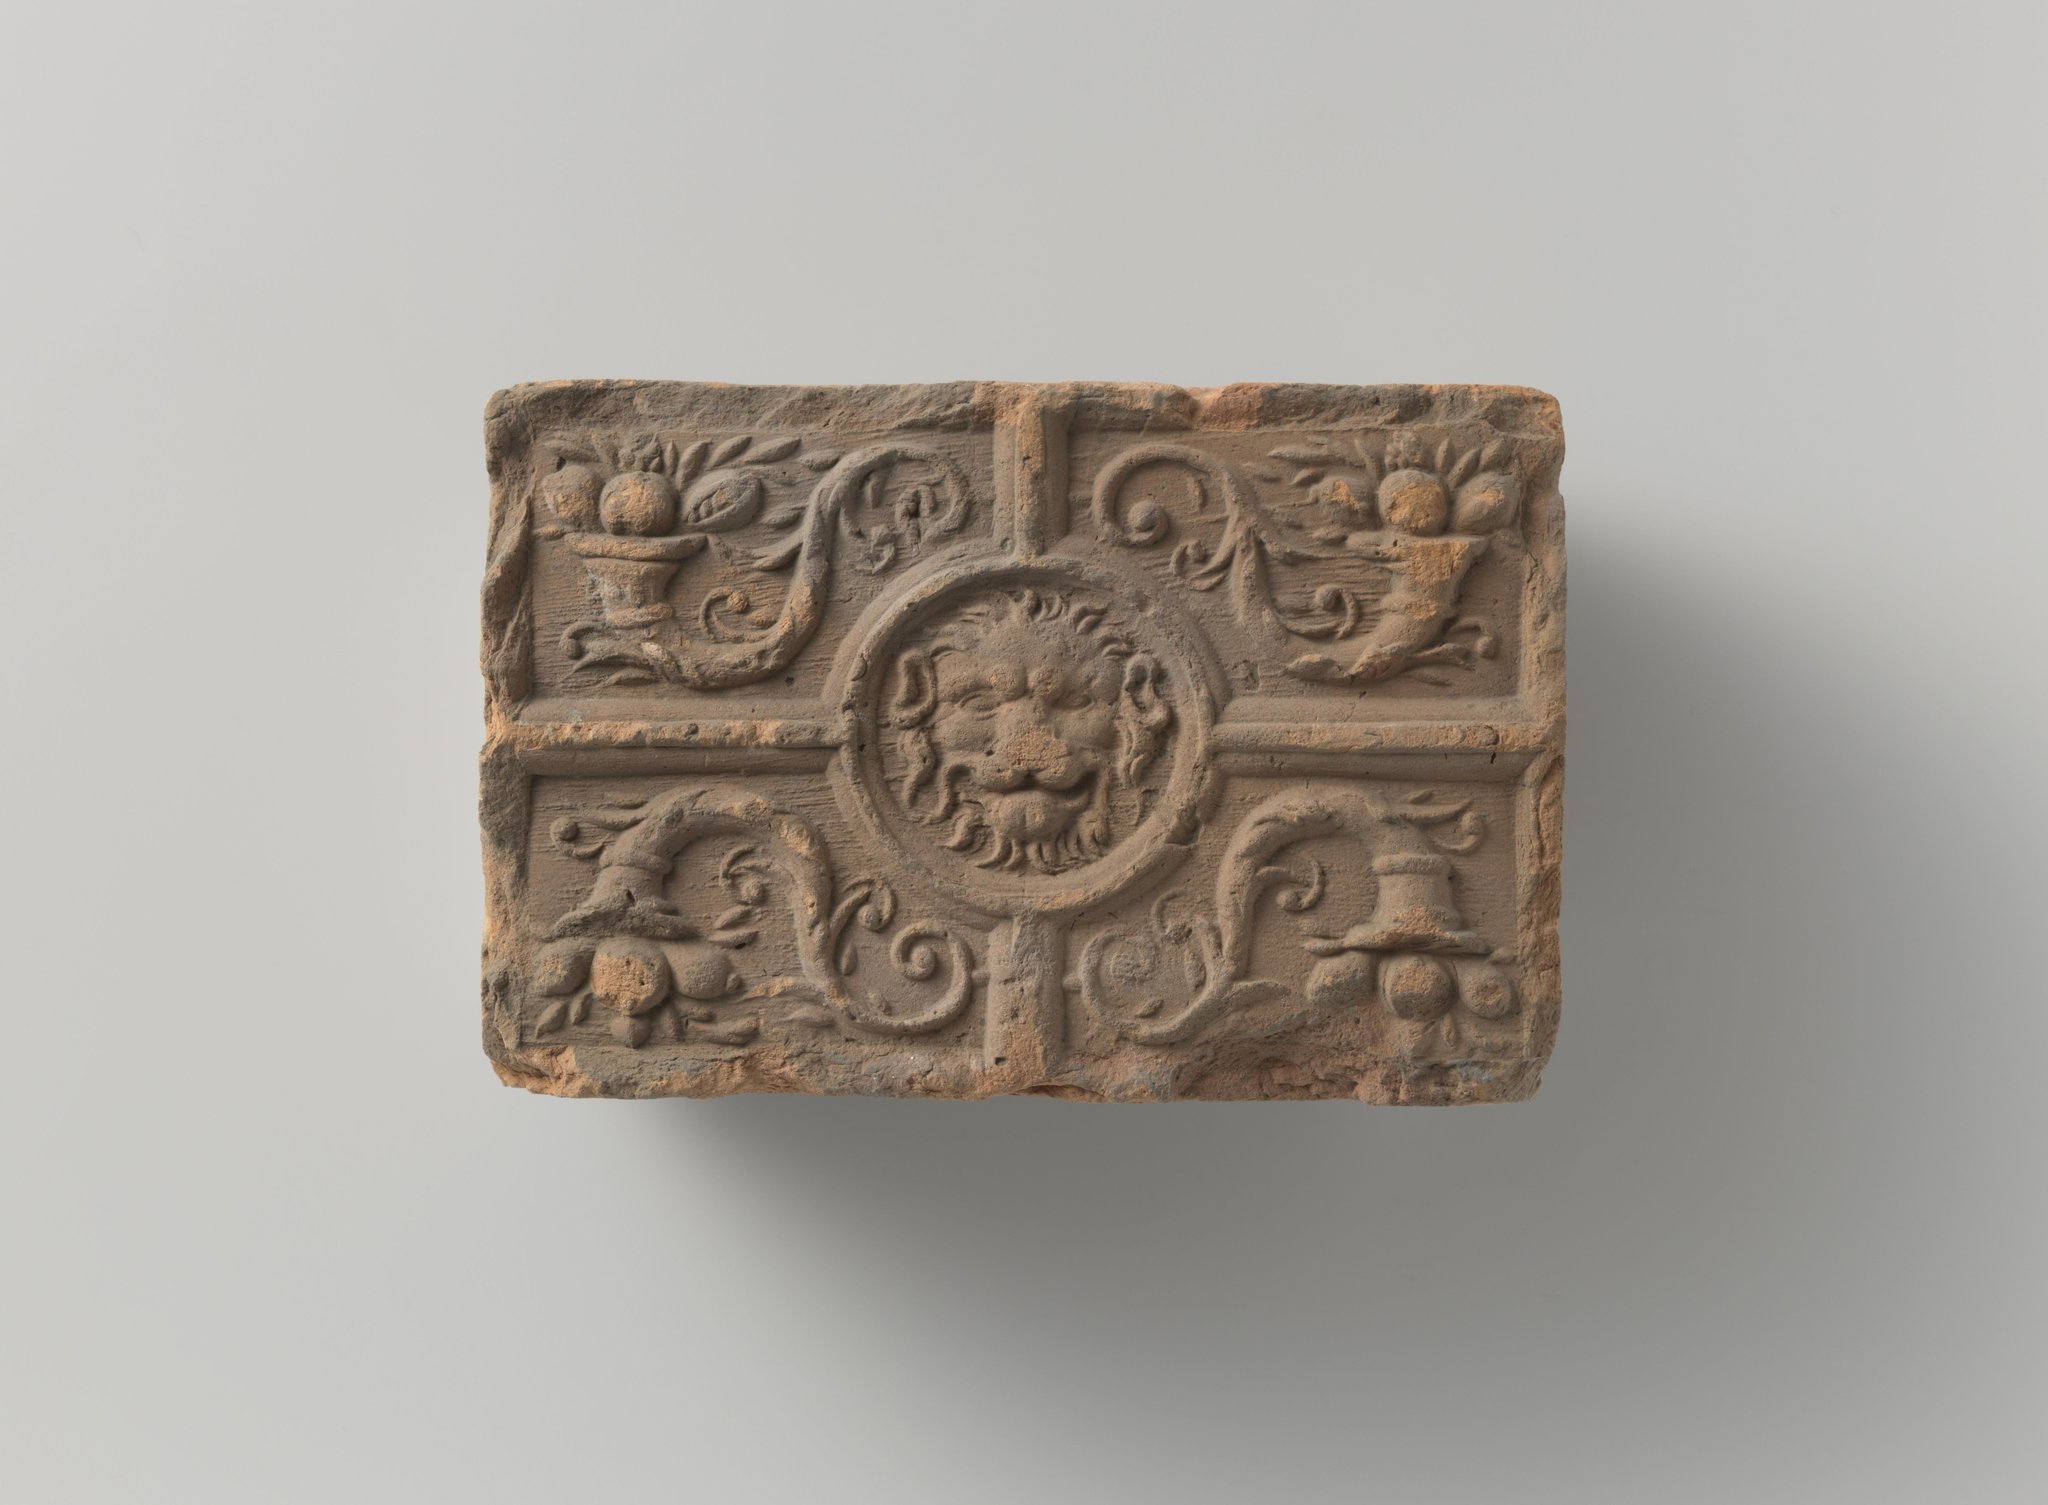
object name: hearthstone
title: Haardsteen met voorstelling van een leeuwenkop in een medaillon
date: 1400-1950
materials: earthenware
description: Haardsteen met voorstelling van een leeuwenkop in een medaillon. Op de hoeken hoornen van overvloed.